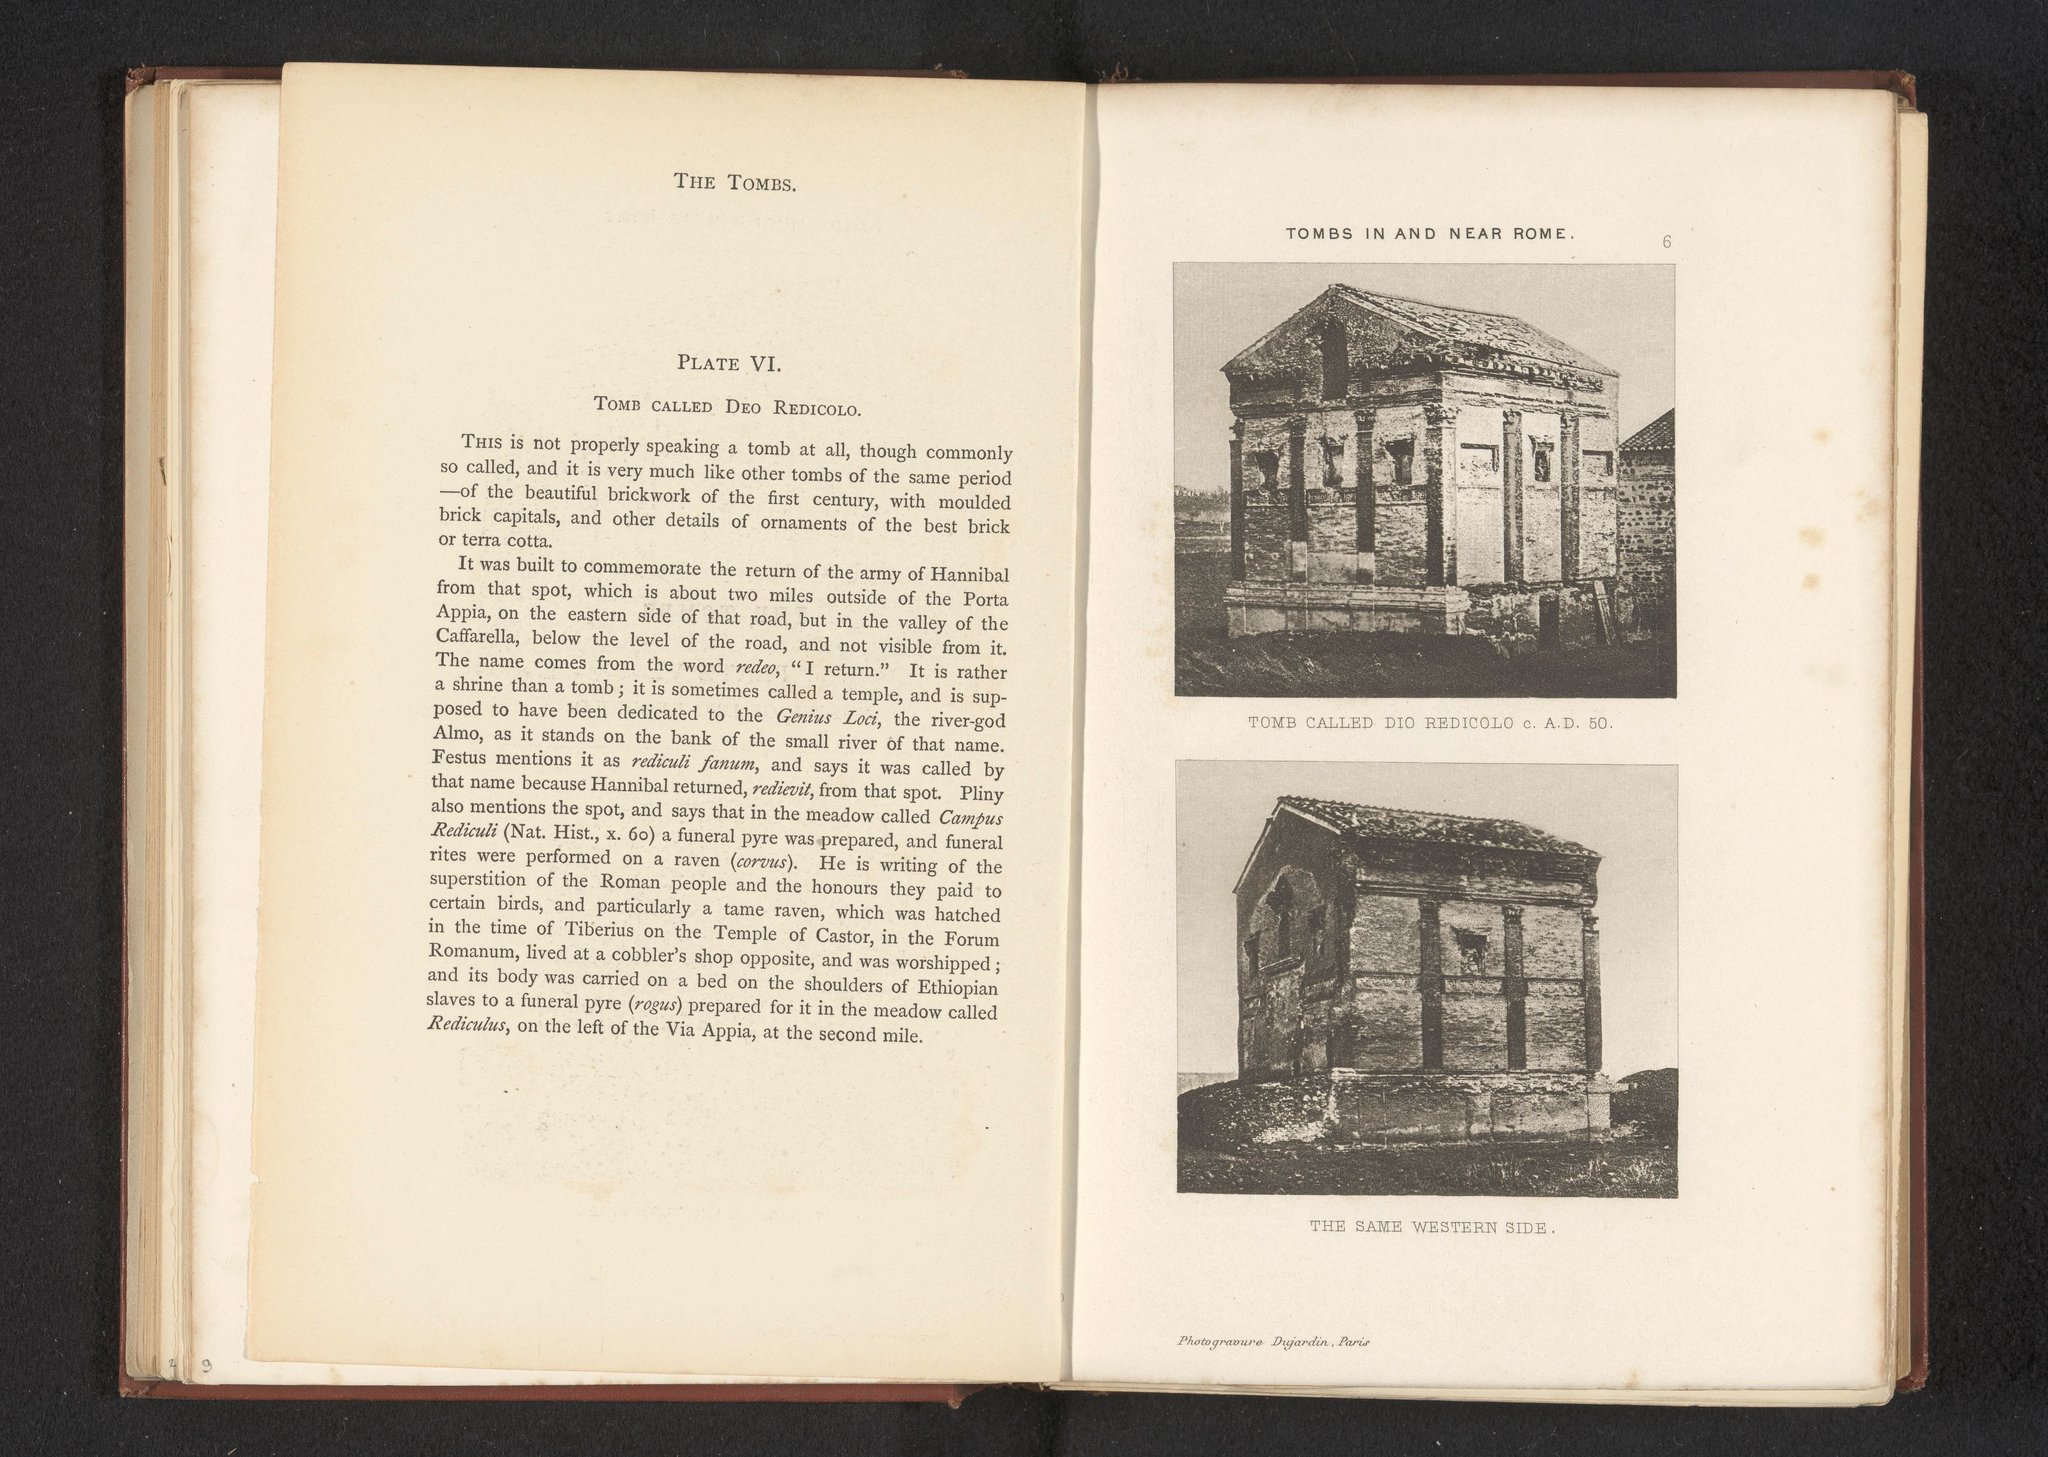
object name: page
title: Tomb called Dio Redicolo c. A.D. 50. The same western side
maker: Anonymous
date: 1867-1877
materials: paper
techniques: photoaquatint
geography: rome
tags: grave, tomb, monument, statue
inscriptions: number: ‘6’